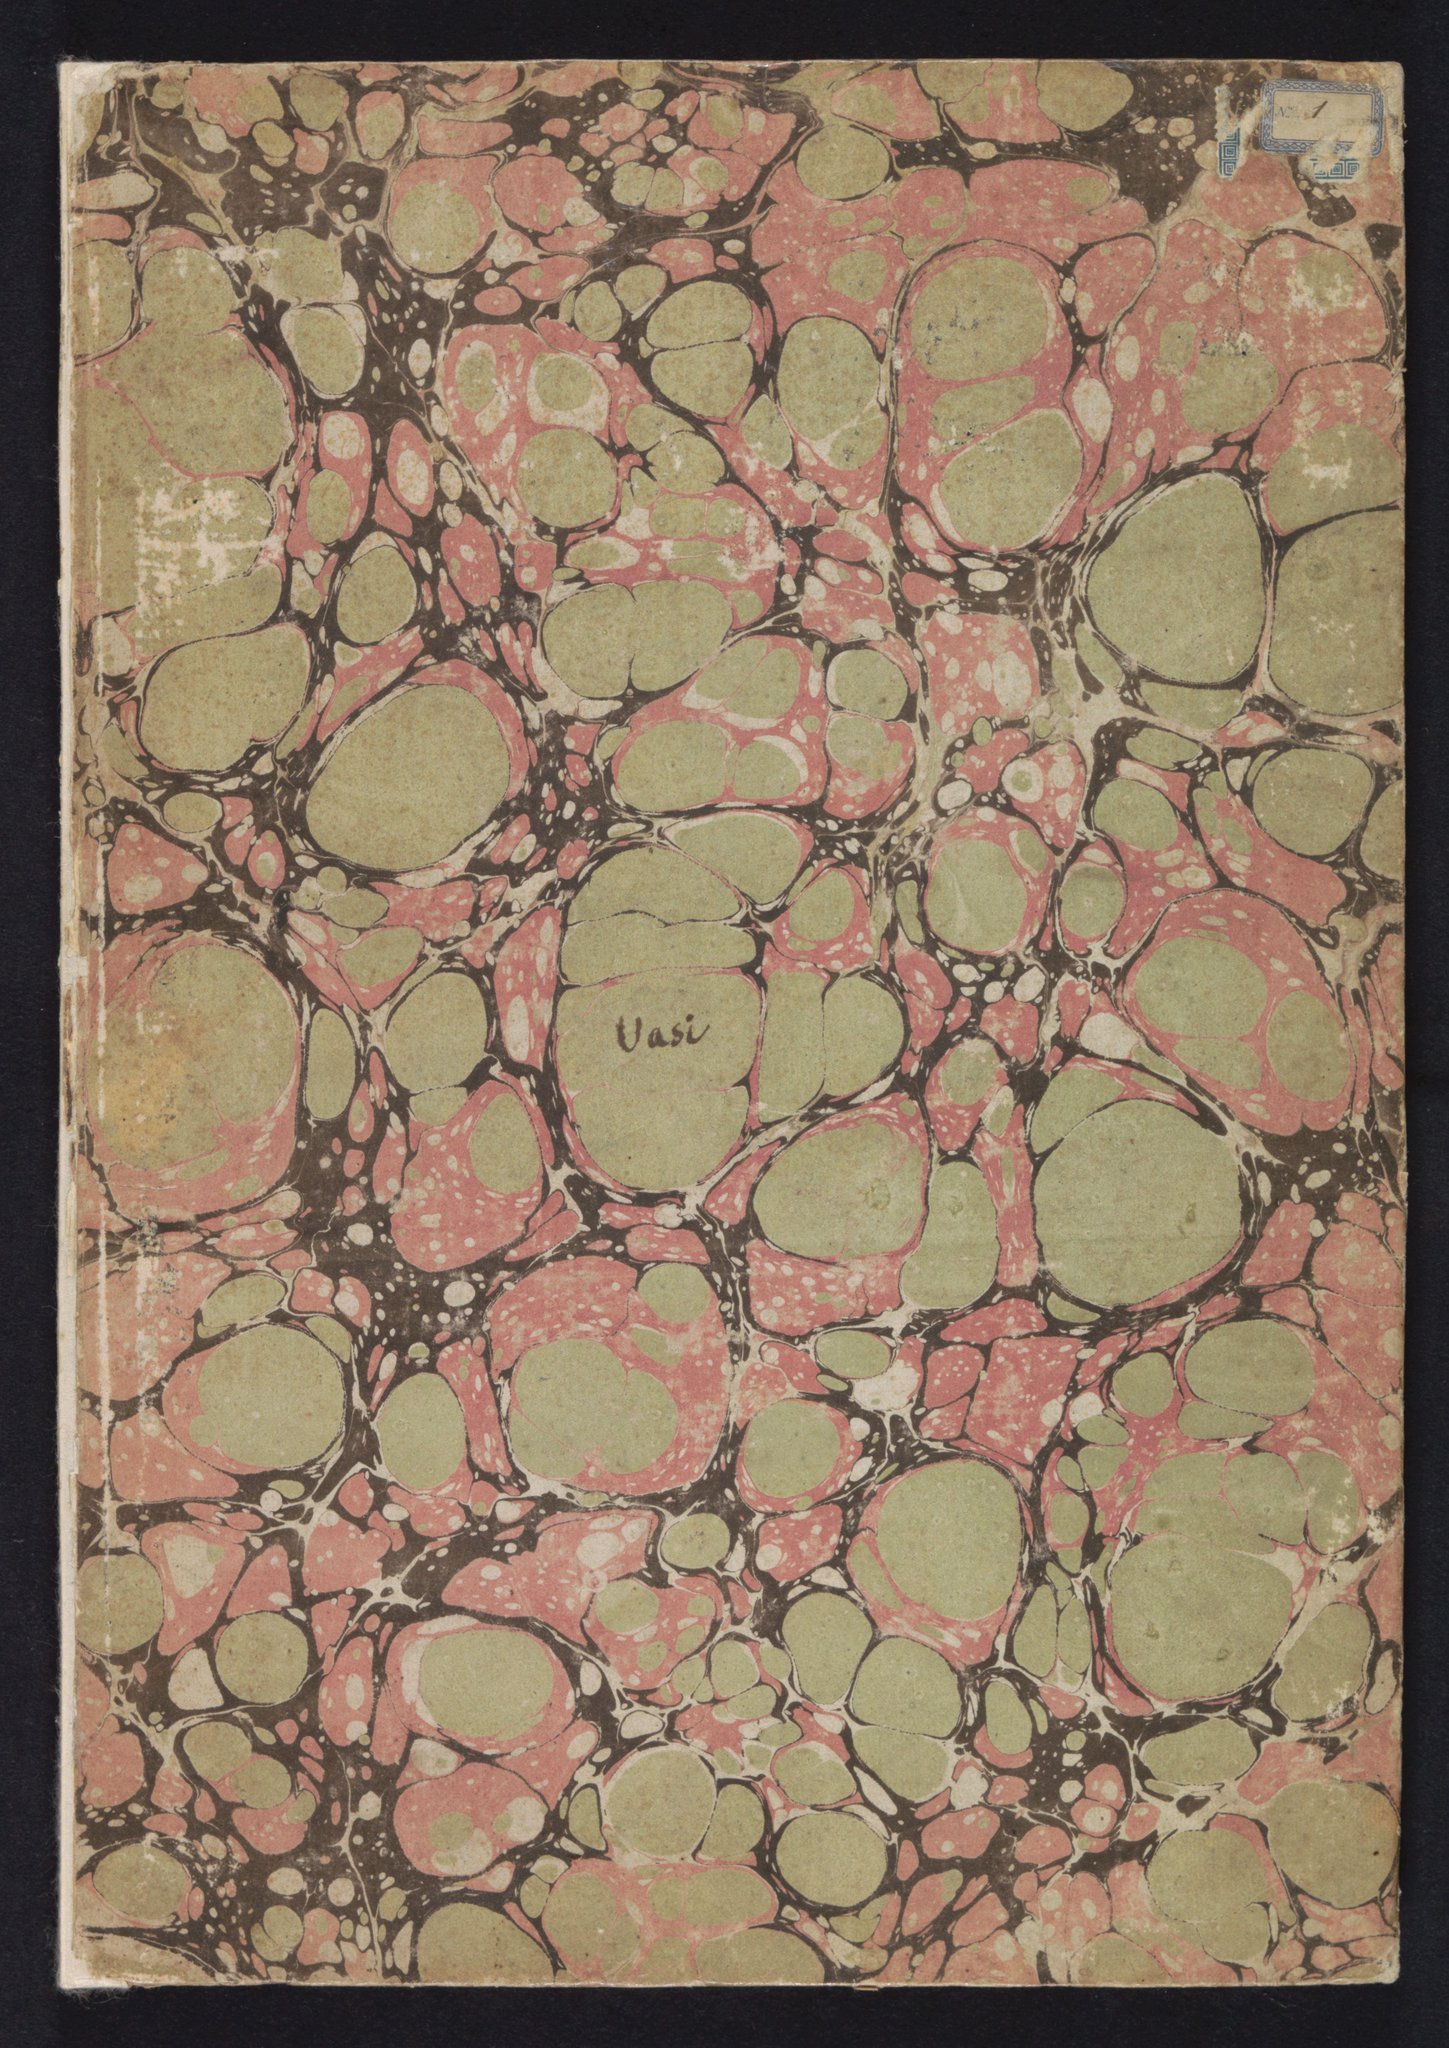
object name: ornament print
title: Album met voorstellingen van verschillende ornamentele vazen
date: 1764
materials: cardboard, paper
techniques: etching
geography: parma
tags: vase ~ ornament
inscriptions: label: ‘Nr. 1’, label: ‘[initialen met kroon erboven] / 7687 / 7688 / 175’, inscription: ‘Vasi’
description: Album met twee titelprenten, drie dedicatiebladen en 30 bladen met prenten van vazen met ornamenten op 35 albumbladen. De dedicatiebladen bevatten tekst over de opdracht van de ontwerper Petitot, de opdracht van de prentmaker Bossi en een tekst gericht aan Monsieur Du Tillot.